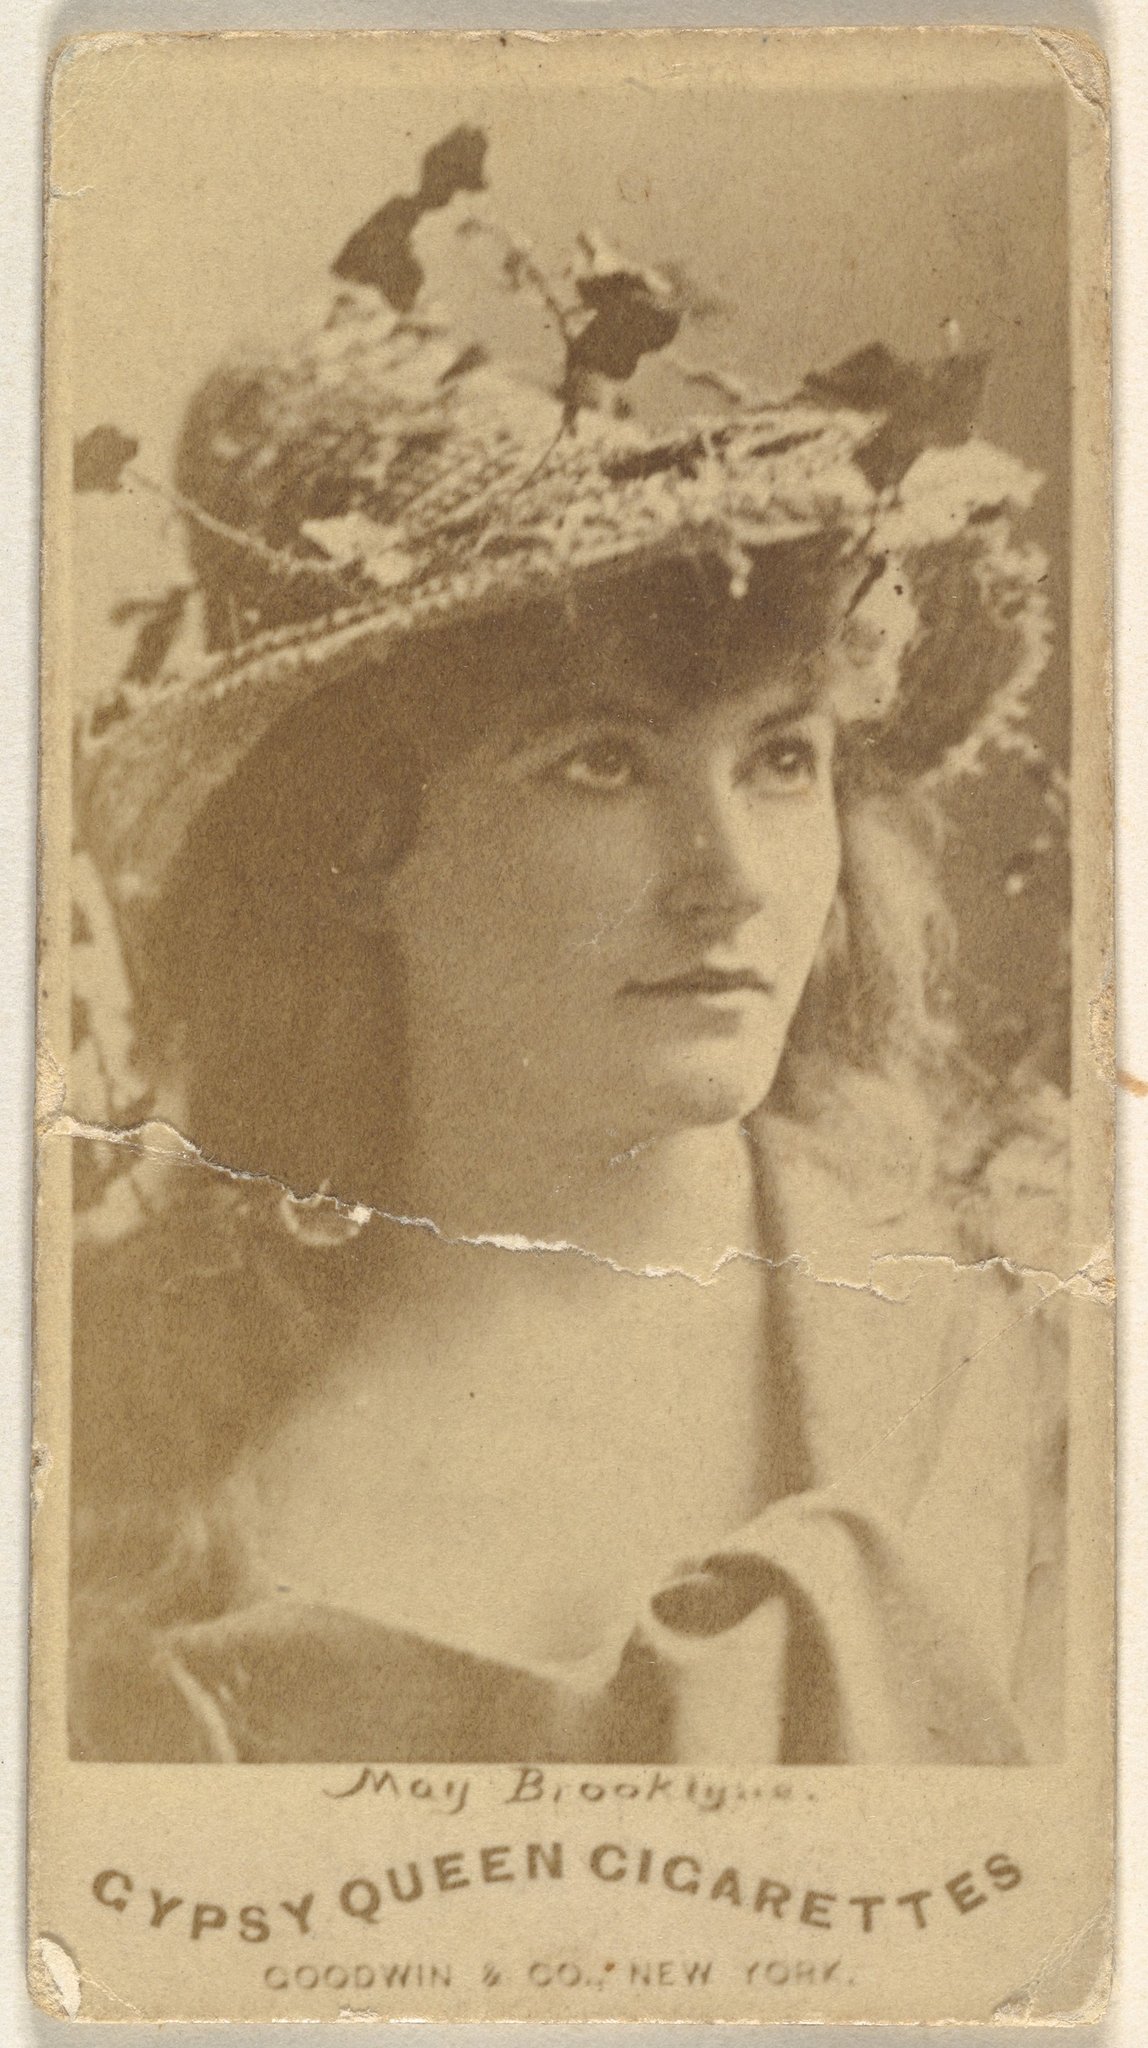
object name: photograph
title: May Brooklyne, from the Actors and Actresses series (N171) for Gypsy Queen Cigarettes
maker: goodwin & company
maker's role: publisher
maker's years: 1850-1950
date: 1886-1890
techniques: albumen silver print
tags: portraits,women,actresses